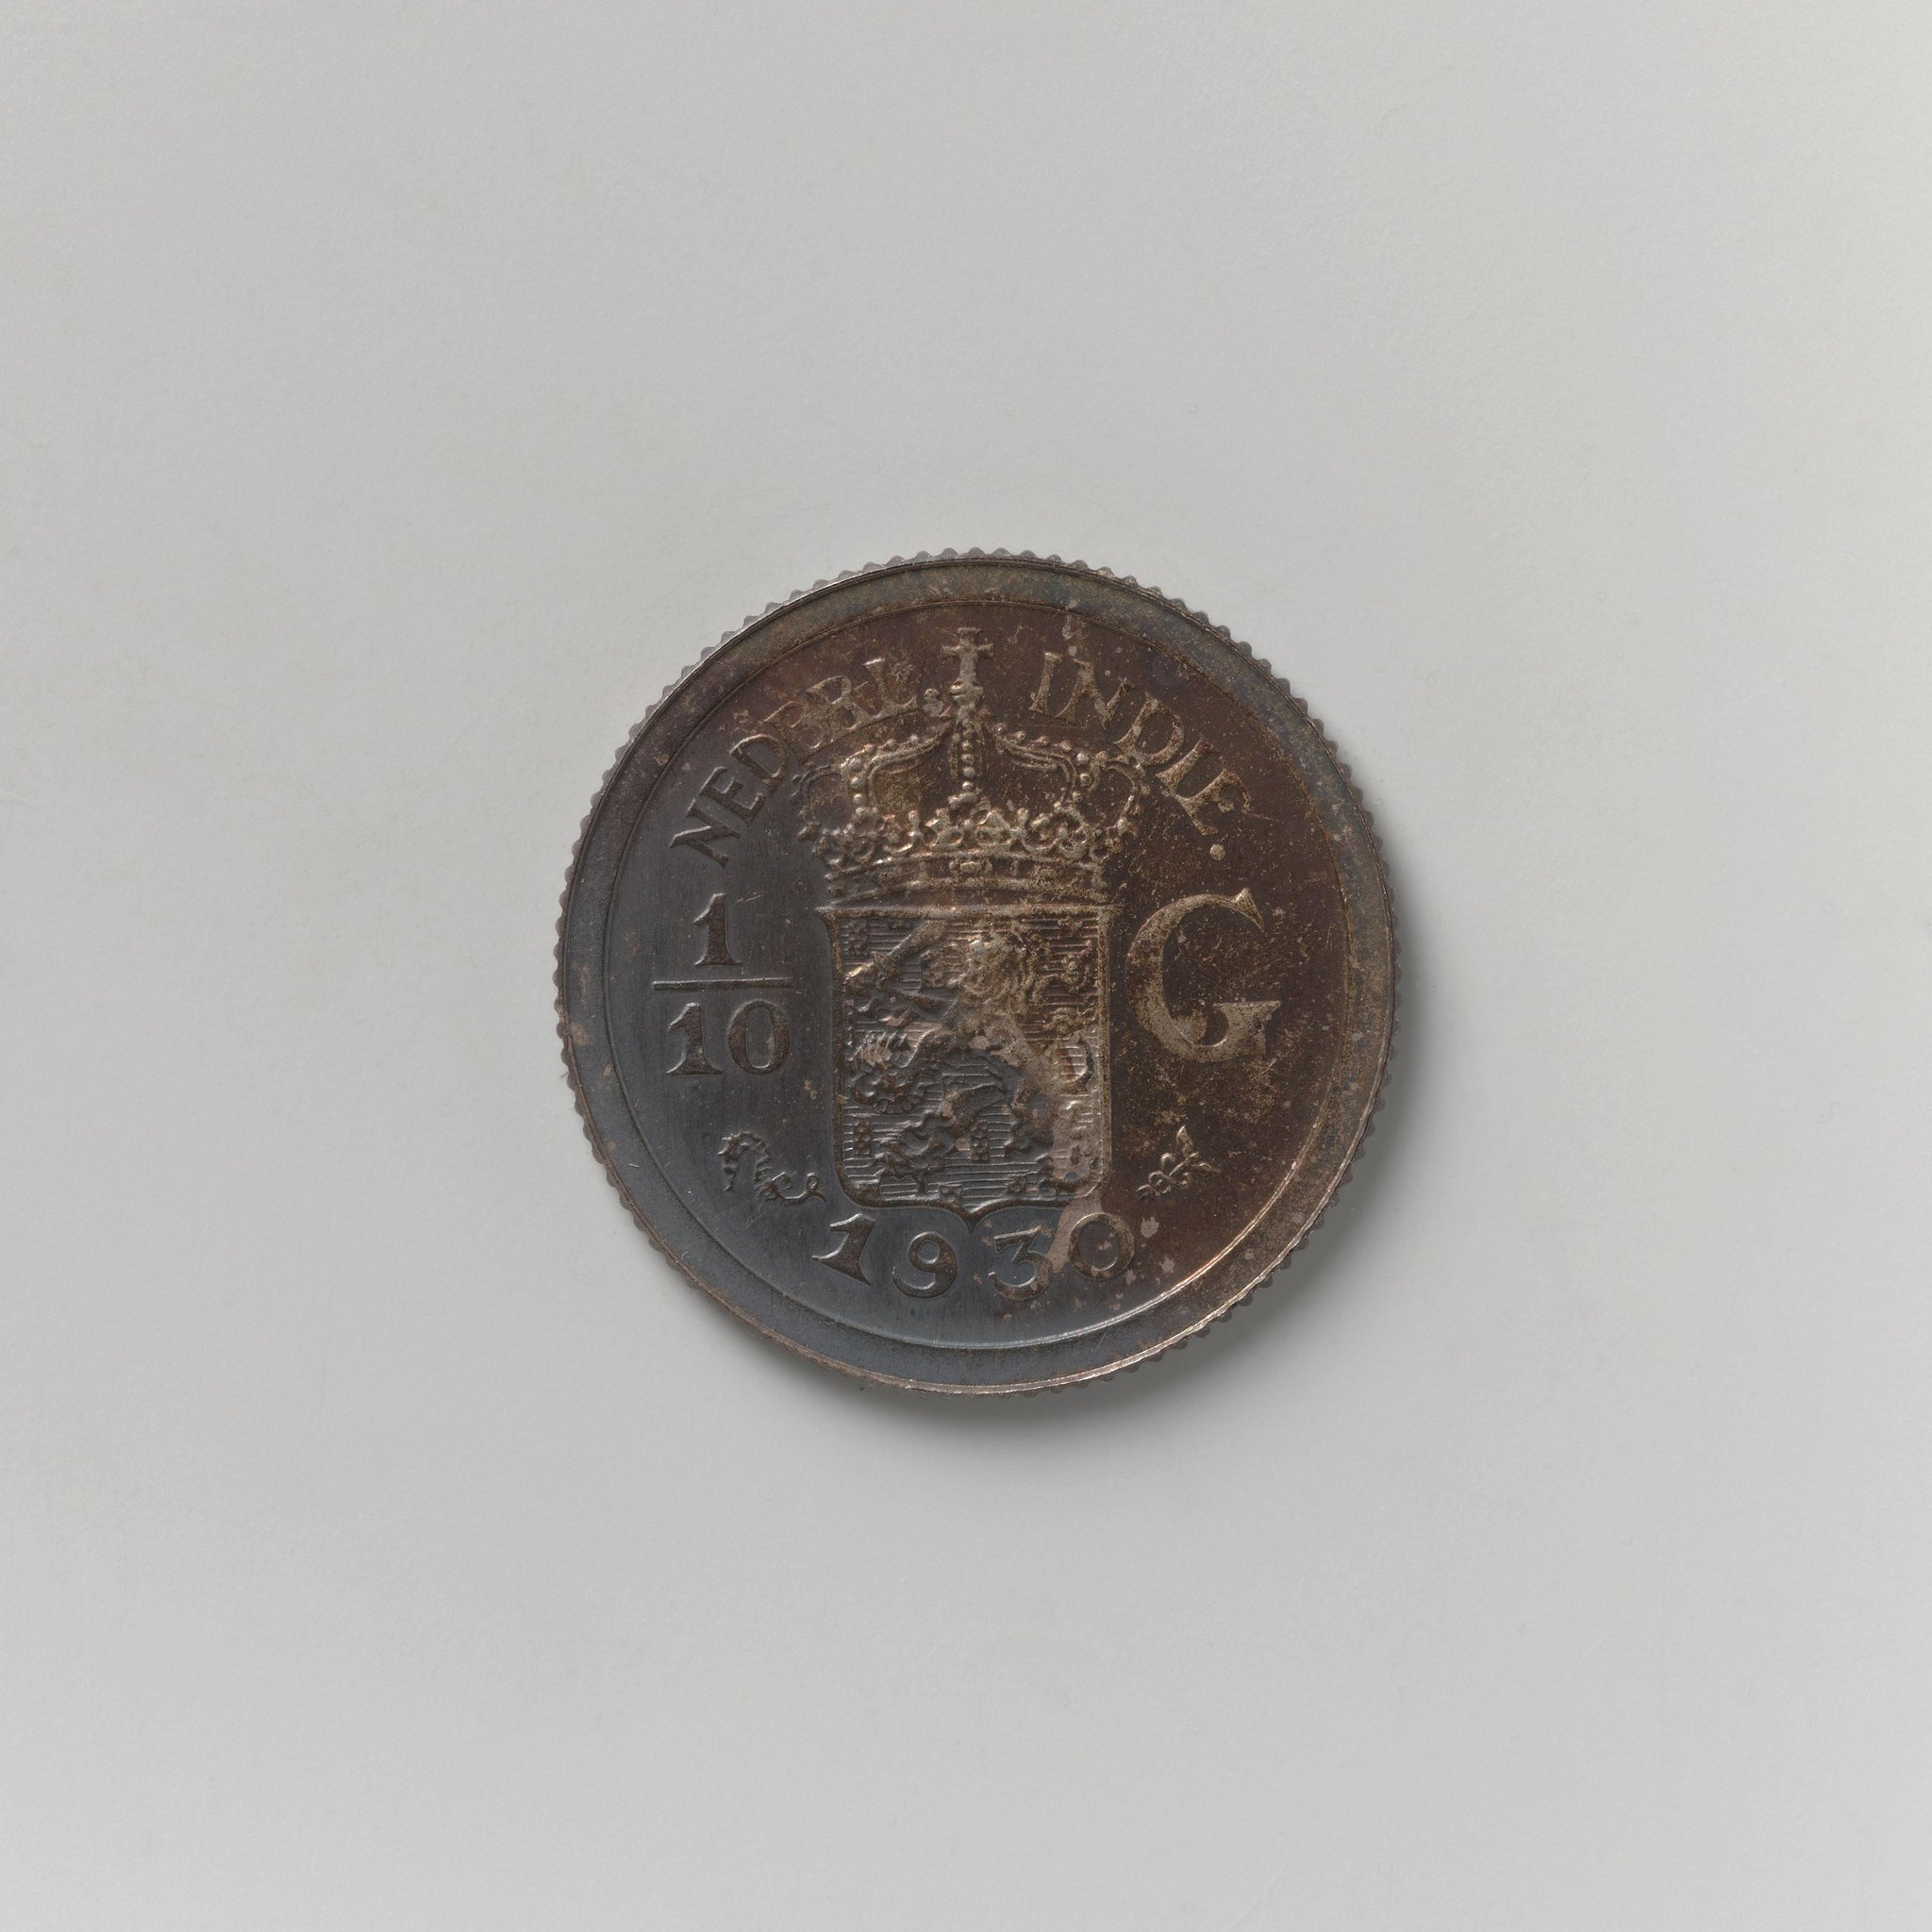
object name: coin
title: 1/10 gulden van Nederlands Indië,1930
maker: wilhelmina of the netherlands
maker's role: print maker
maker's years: 1880-1962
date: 1930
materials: copper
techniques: striking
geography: utrecht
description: Zilveren munt. Voorzijde: tussen waarde-aanduiding 1/10 G gekroond rijkswapenschild. Boven kroon landsaanduiding en onder wapenschild jaartal. Keerzijde: tweeregelig Maleis opschrift in Arabische tekens, waaromheen omschrift in het Javaans. Kartelrand.